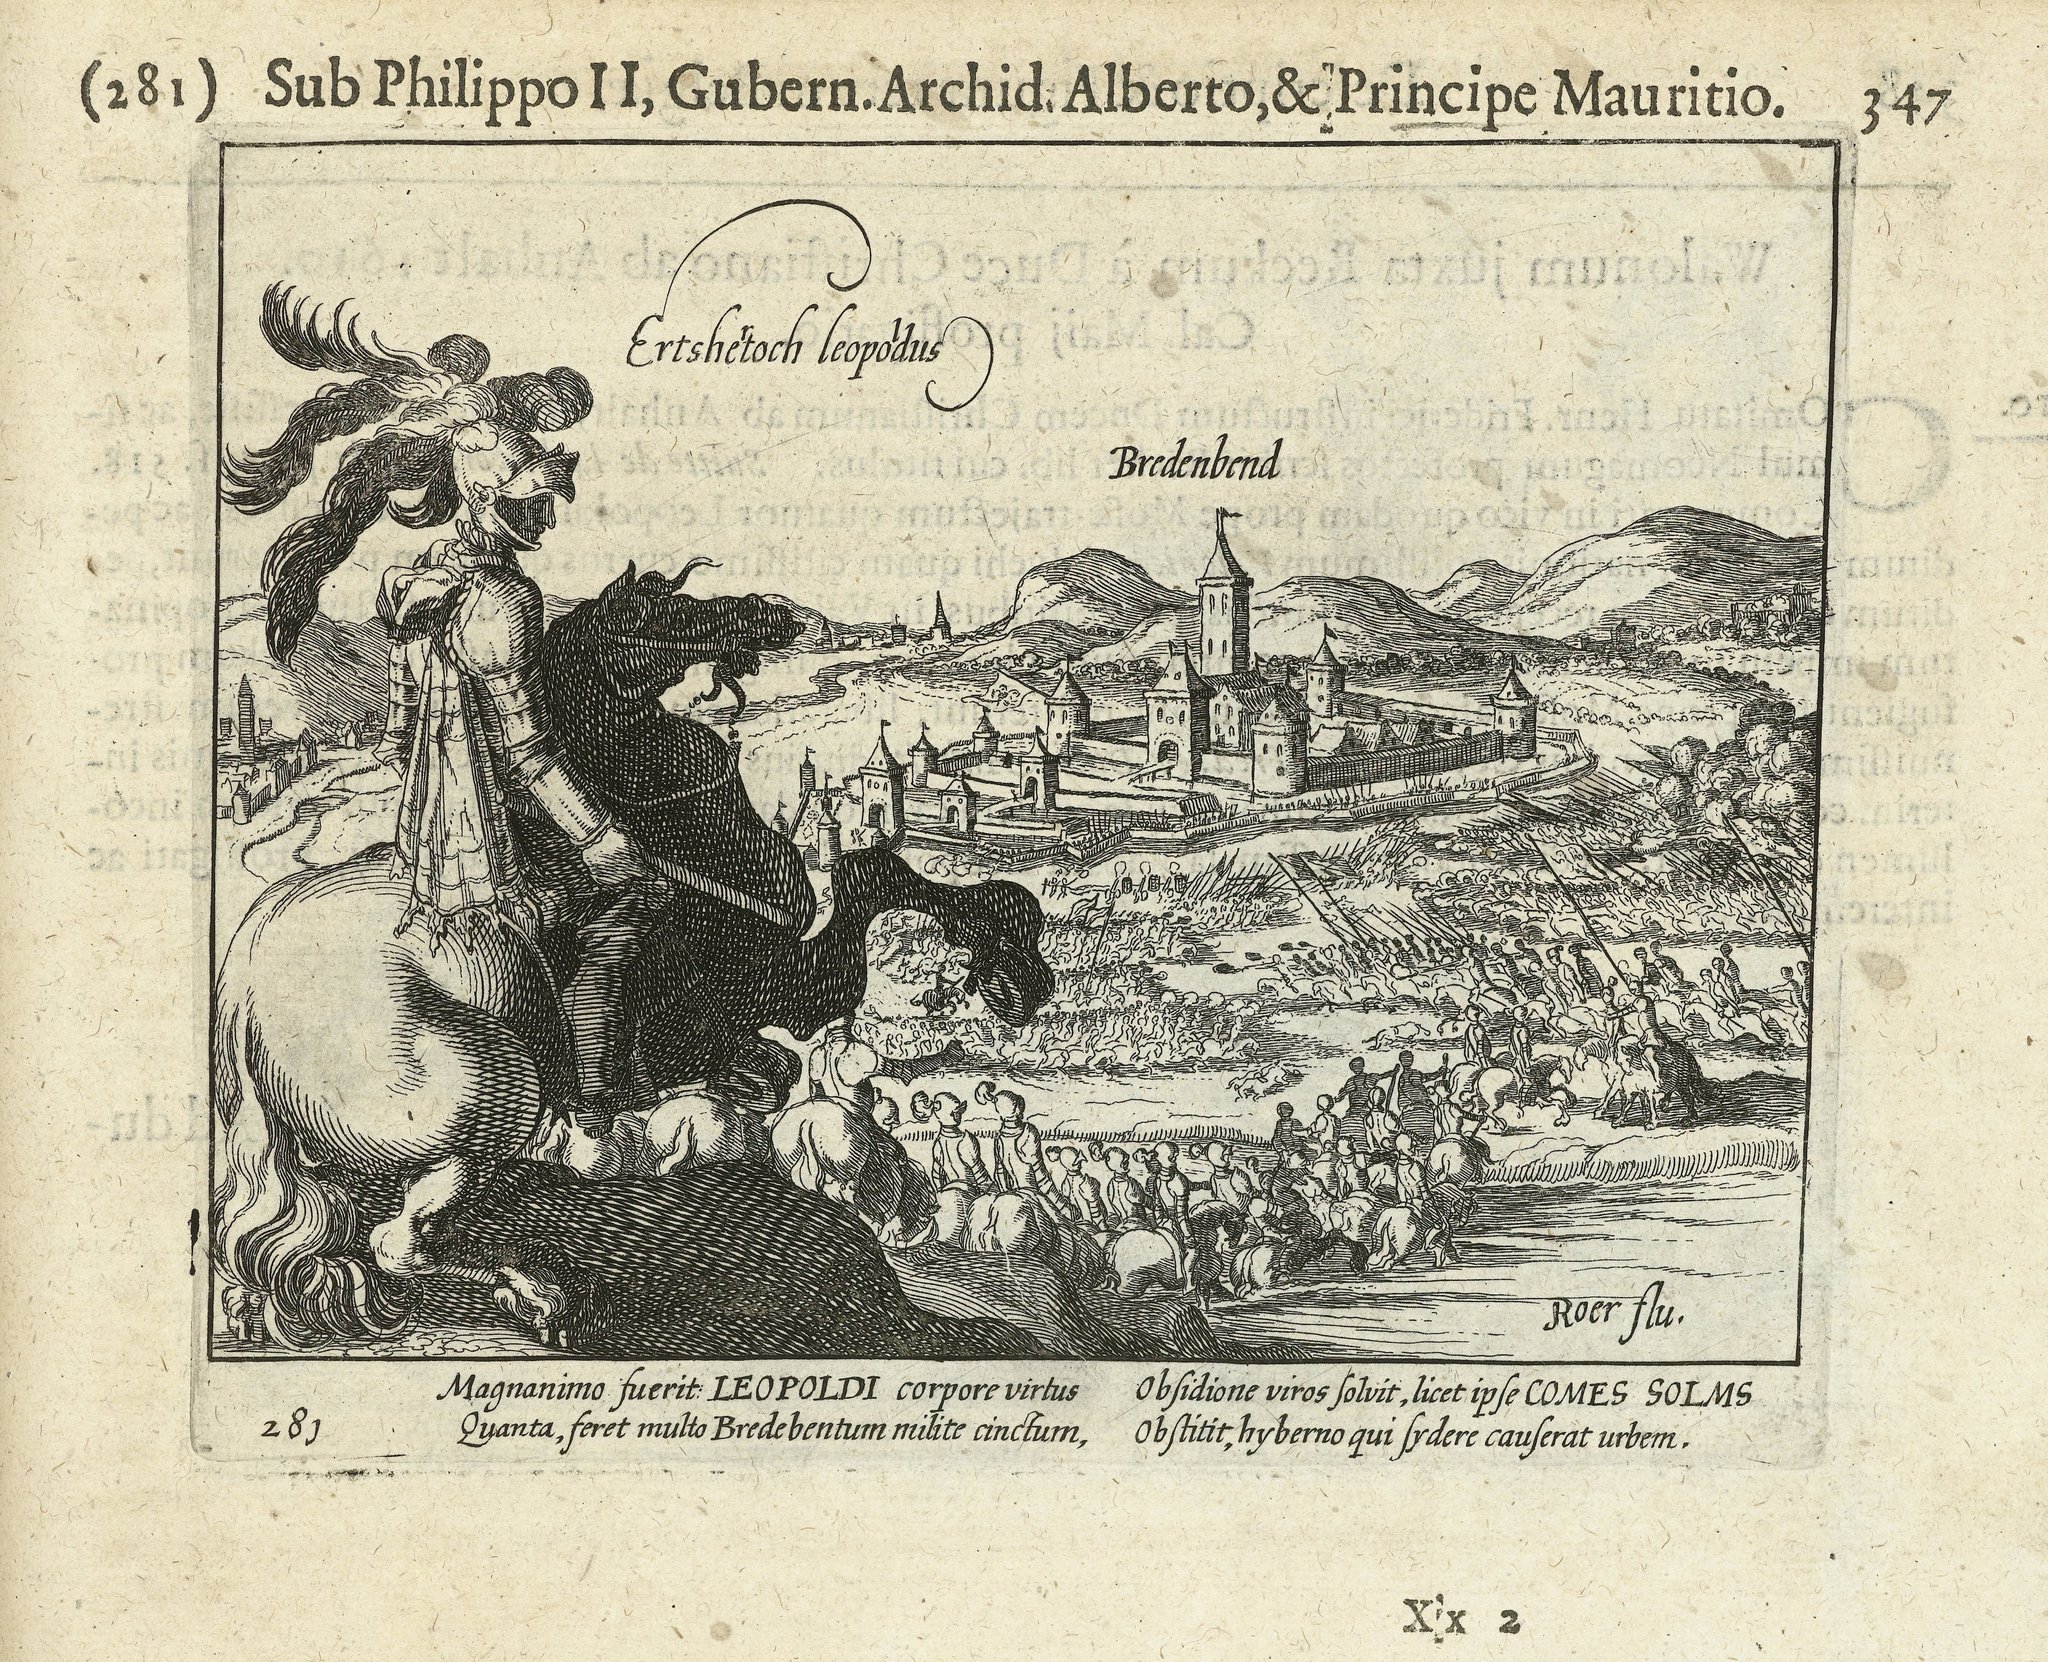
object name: print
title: Aartshertog Leopold ontzet Breitenbend, 1610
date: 1613-1615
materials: paper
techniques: etching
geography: amsterdam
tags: leopold v (aartshertog van oostenrijk), raising the siege with outside assistance, relief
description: Aartshertog Leopold ontzet Breitenbend, 12 maart 1610. Op de voorgrond ziet de aartshertog te paard hoe zijn leger de rivier de Ruhr doorsteekt op weg naar de stad Breitenbend dat door het Staatse leger belegerd wordt. Met onderschrift van 4 regels in het Latijn. Genummerd: 281. Bedrukt op achterzijde met tekst in het Latijn.